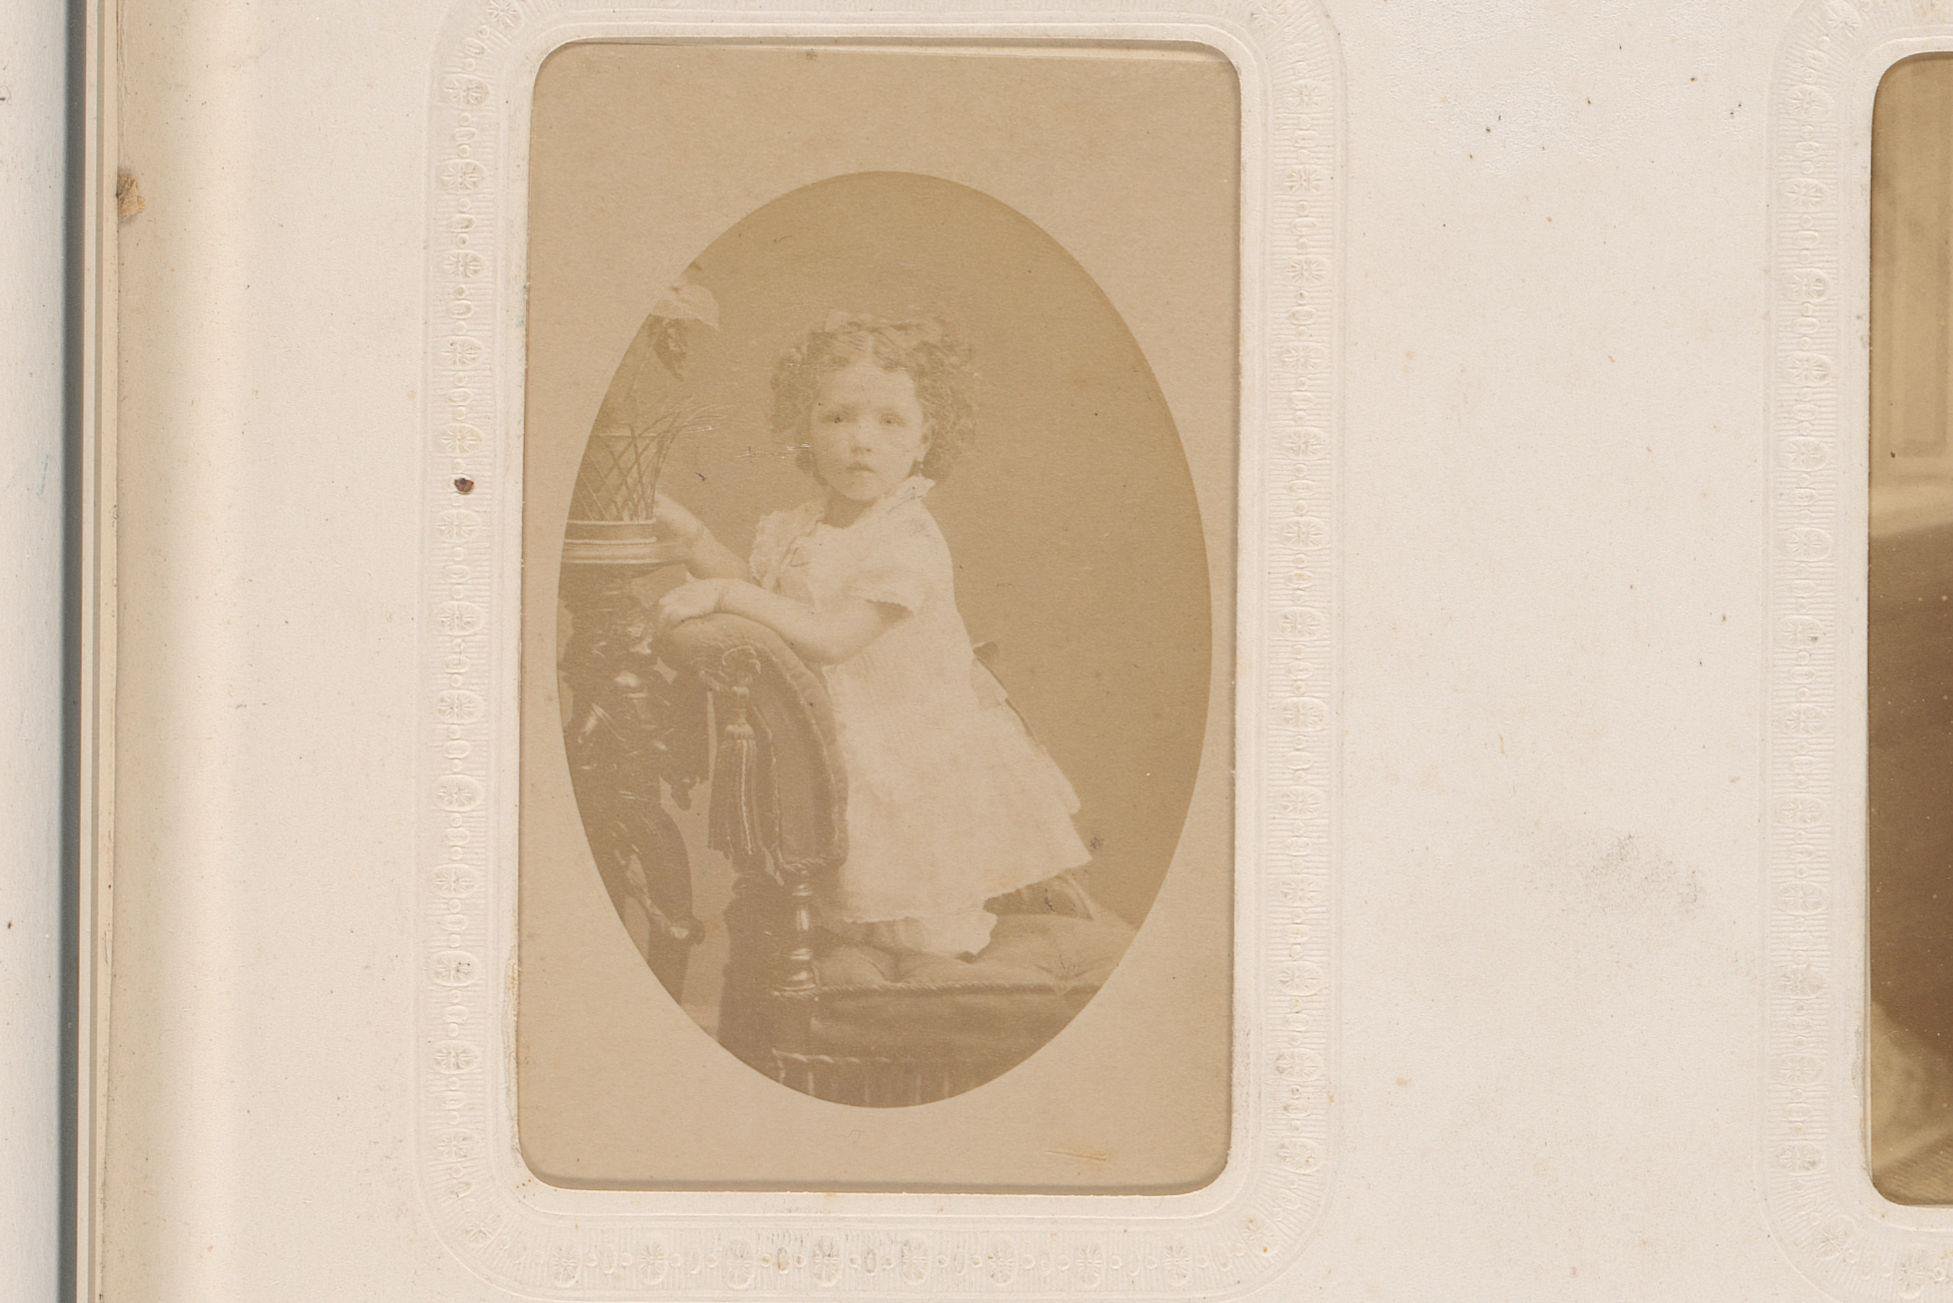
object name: photograph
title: Portret van een meisje, leunend op de leuning van een stoel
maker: Anonymous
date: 1860-1900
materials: cardboard, photographic support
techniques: albumen print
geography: netherlands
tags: historical persons - bb - woman, leaning figure - aa - female human figure, girl (child between toddler and youth)